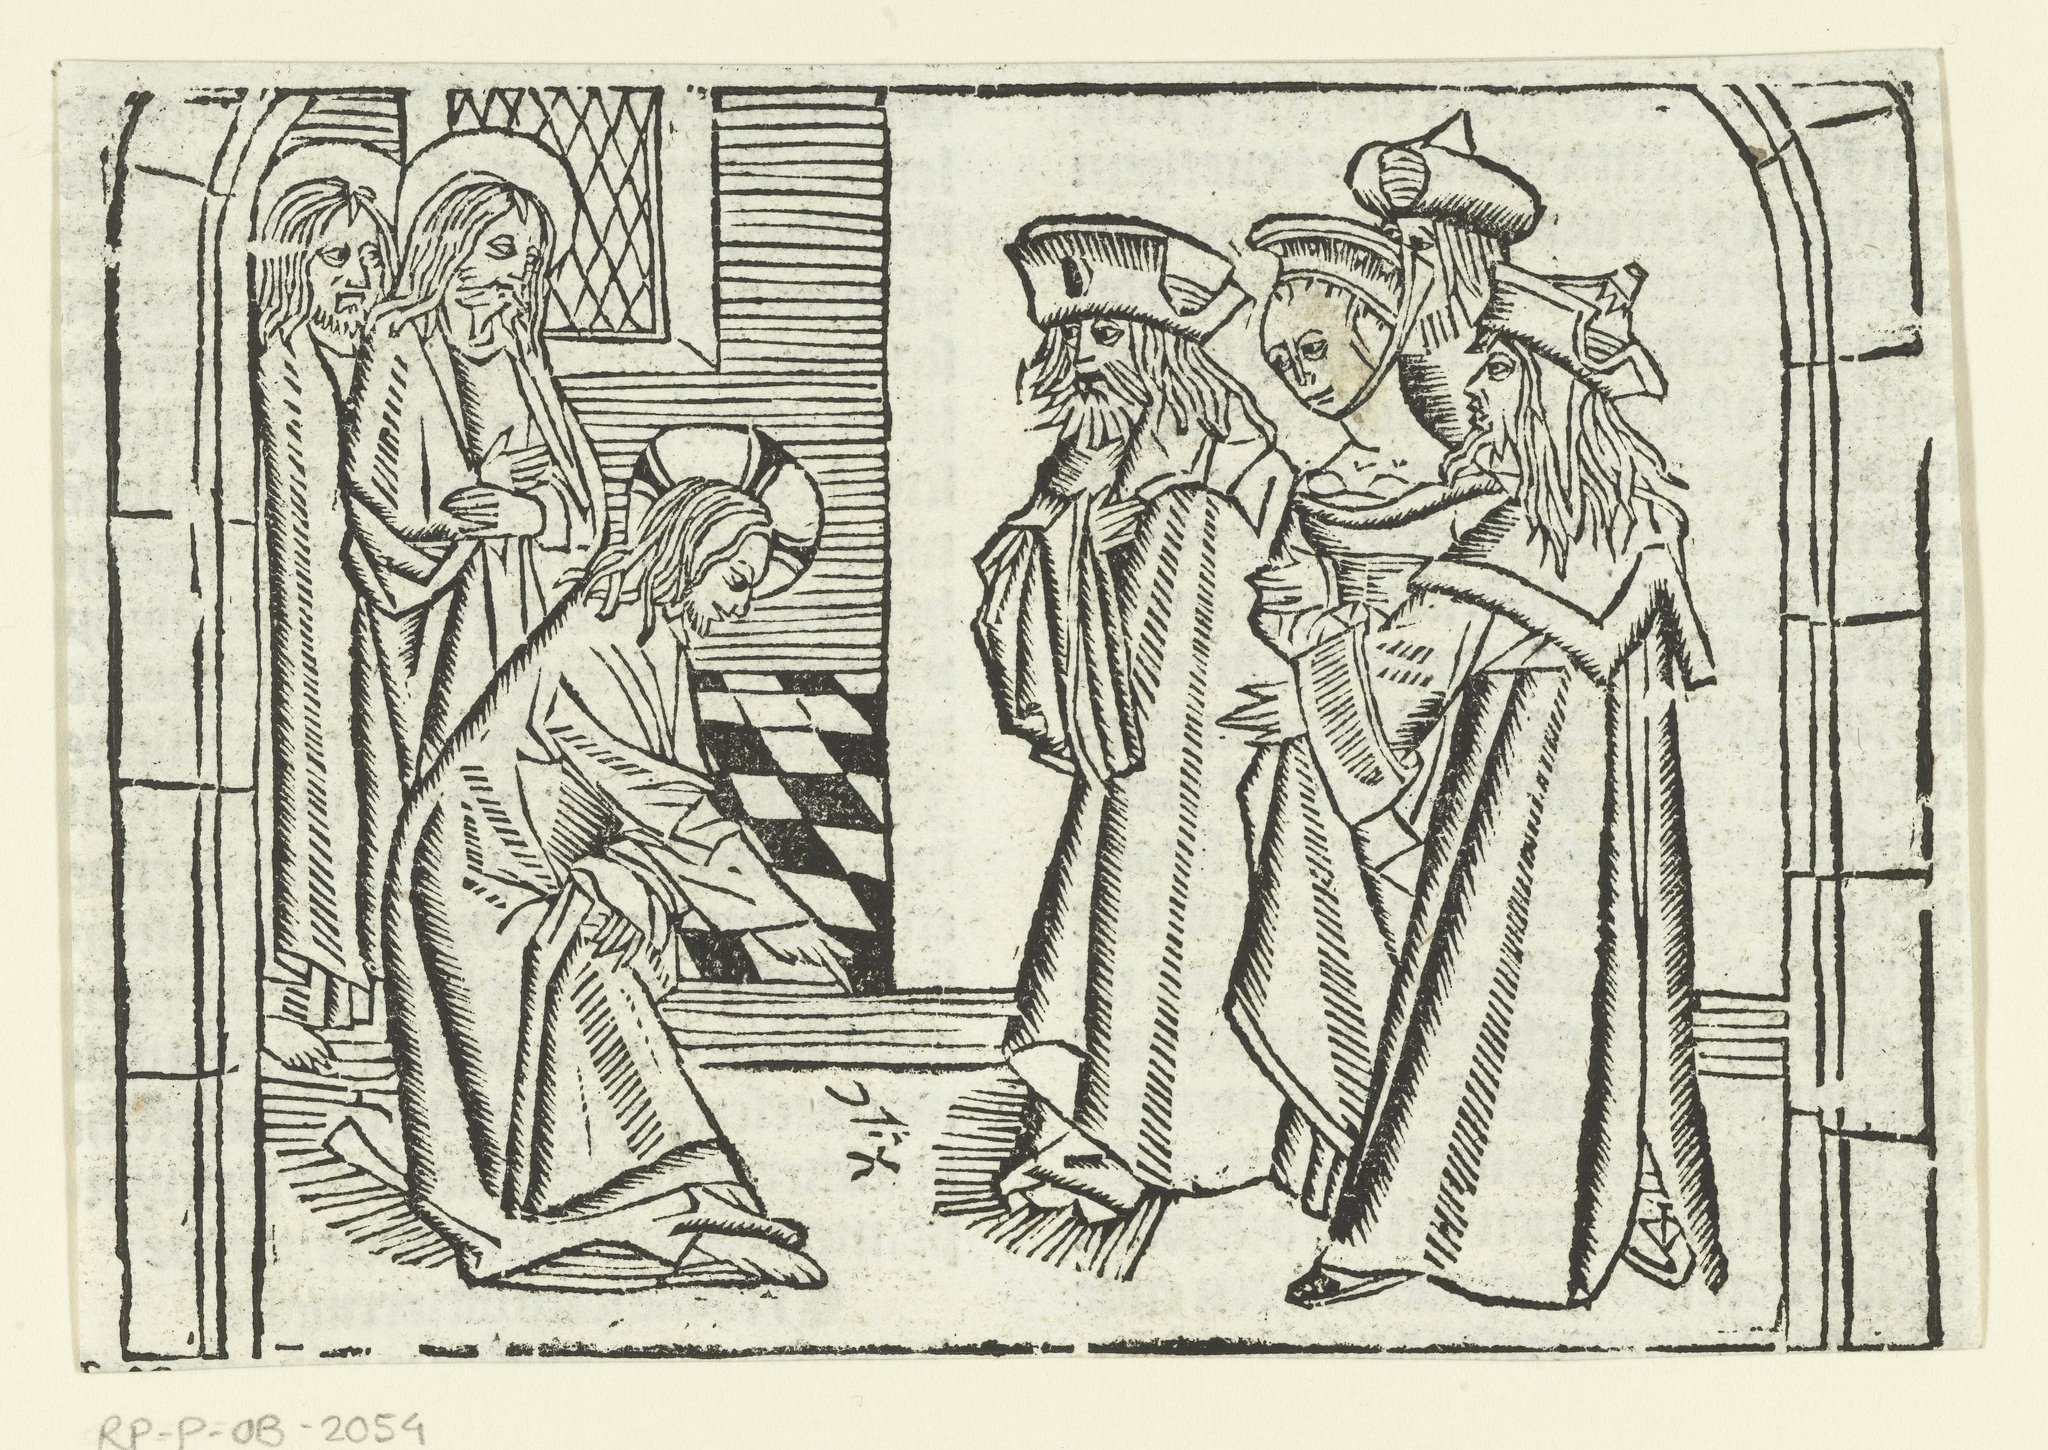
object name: print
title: Christus en de overspelige vrouw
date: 1480-1500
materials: paper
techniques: woodcut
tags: pharisees bring a woman accused of adultery before christ (john 8:2-11)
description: Eén blad van 113 uit Ludolphus de Saxonia, "Dit es dleué ons liefs heeren ihesu christi". Anonieme Nederlandse vertaling. Uitgegeven door Henrick Eckert van Homberch te Antwerpen in 1503. Botke, K. Deze 113 houtsneden, die meestal reeds in vroege Nederlandse boeken gebruikt zijn, worden toegeschreven aan de tweede Meester van Delft, de Meester van de Delbecq-Schreiber-passie en de Meester van de Virgo inter Virgines. In Conway (1884) en in "De gulden passer"(1951) zijn ook eerdere versies opgenomen. Botke, K.